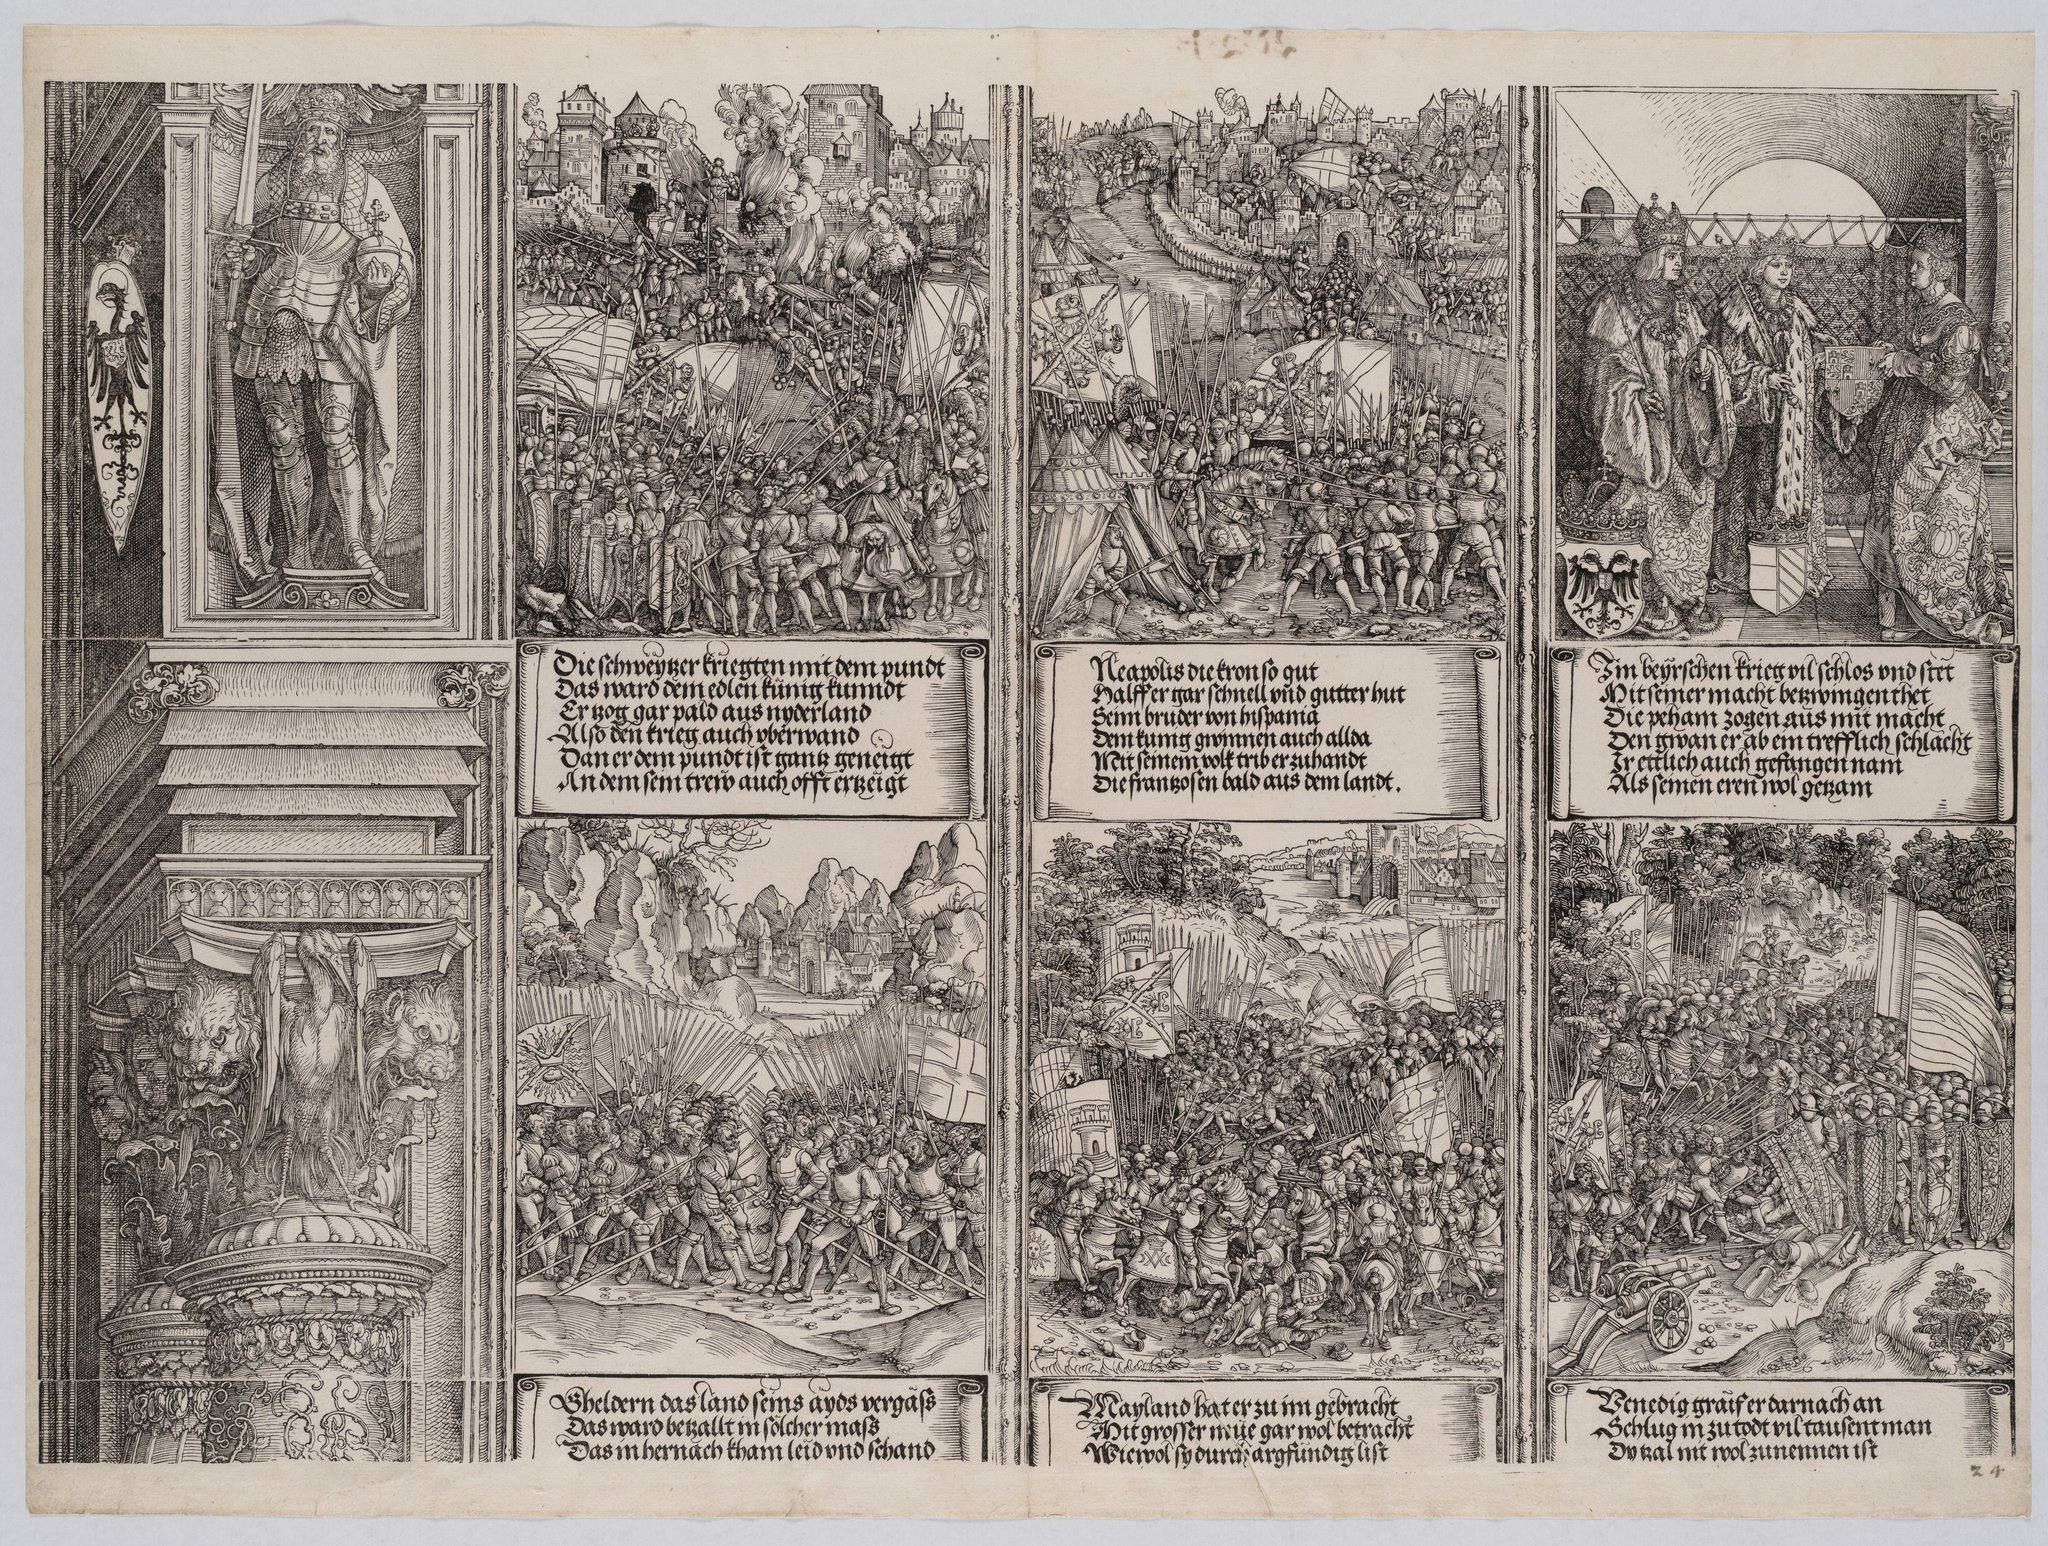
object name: print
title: The Marriage of Philip the Fair to Joanna of Austria; Maximilian Recaptures the Occupied Territories from Hungary; The Conquest of Hungary; The Swiss War; The Liberation of Naples; and The Battle of Wenzenberg, from the Arch of Honor, proof, dated 1515, printed 1517-18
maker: albrecht dürer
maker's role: artist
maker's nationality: german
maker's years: 1471-1528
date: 1515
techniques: letterpress, woodcut